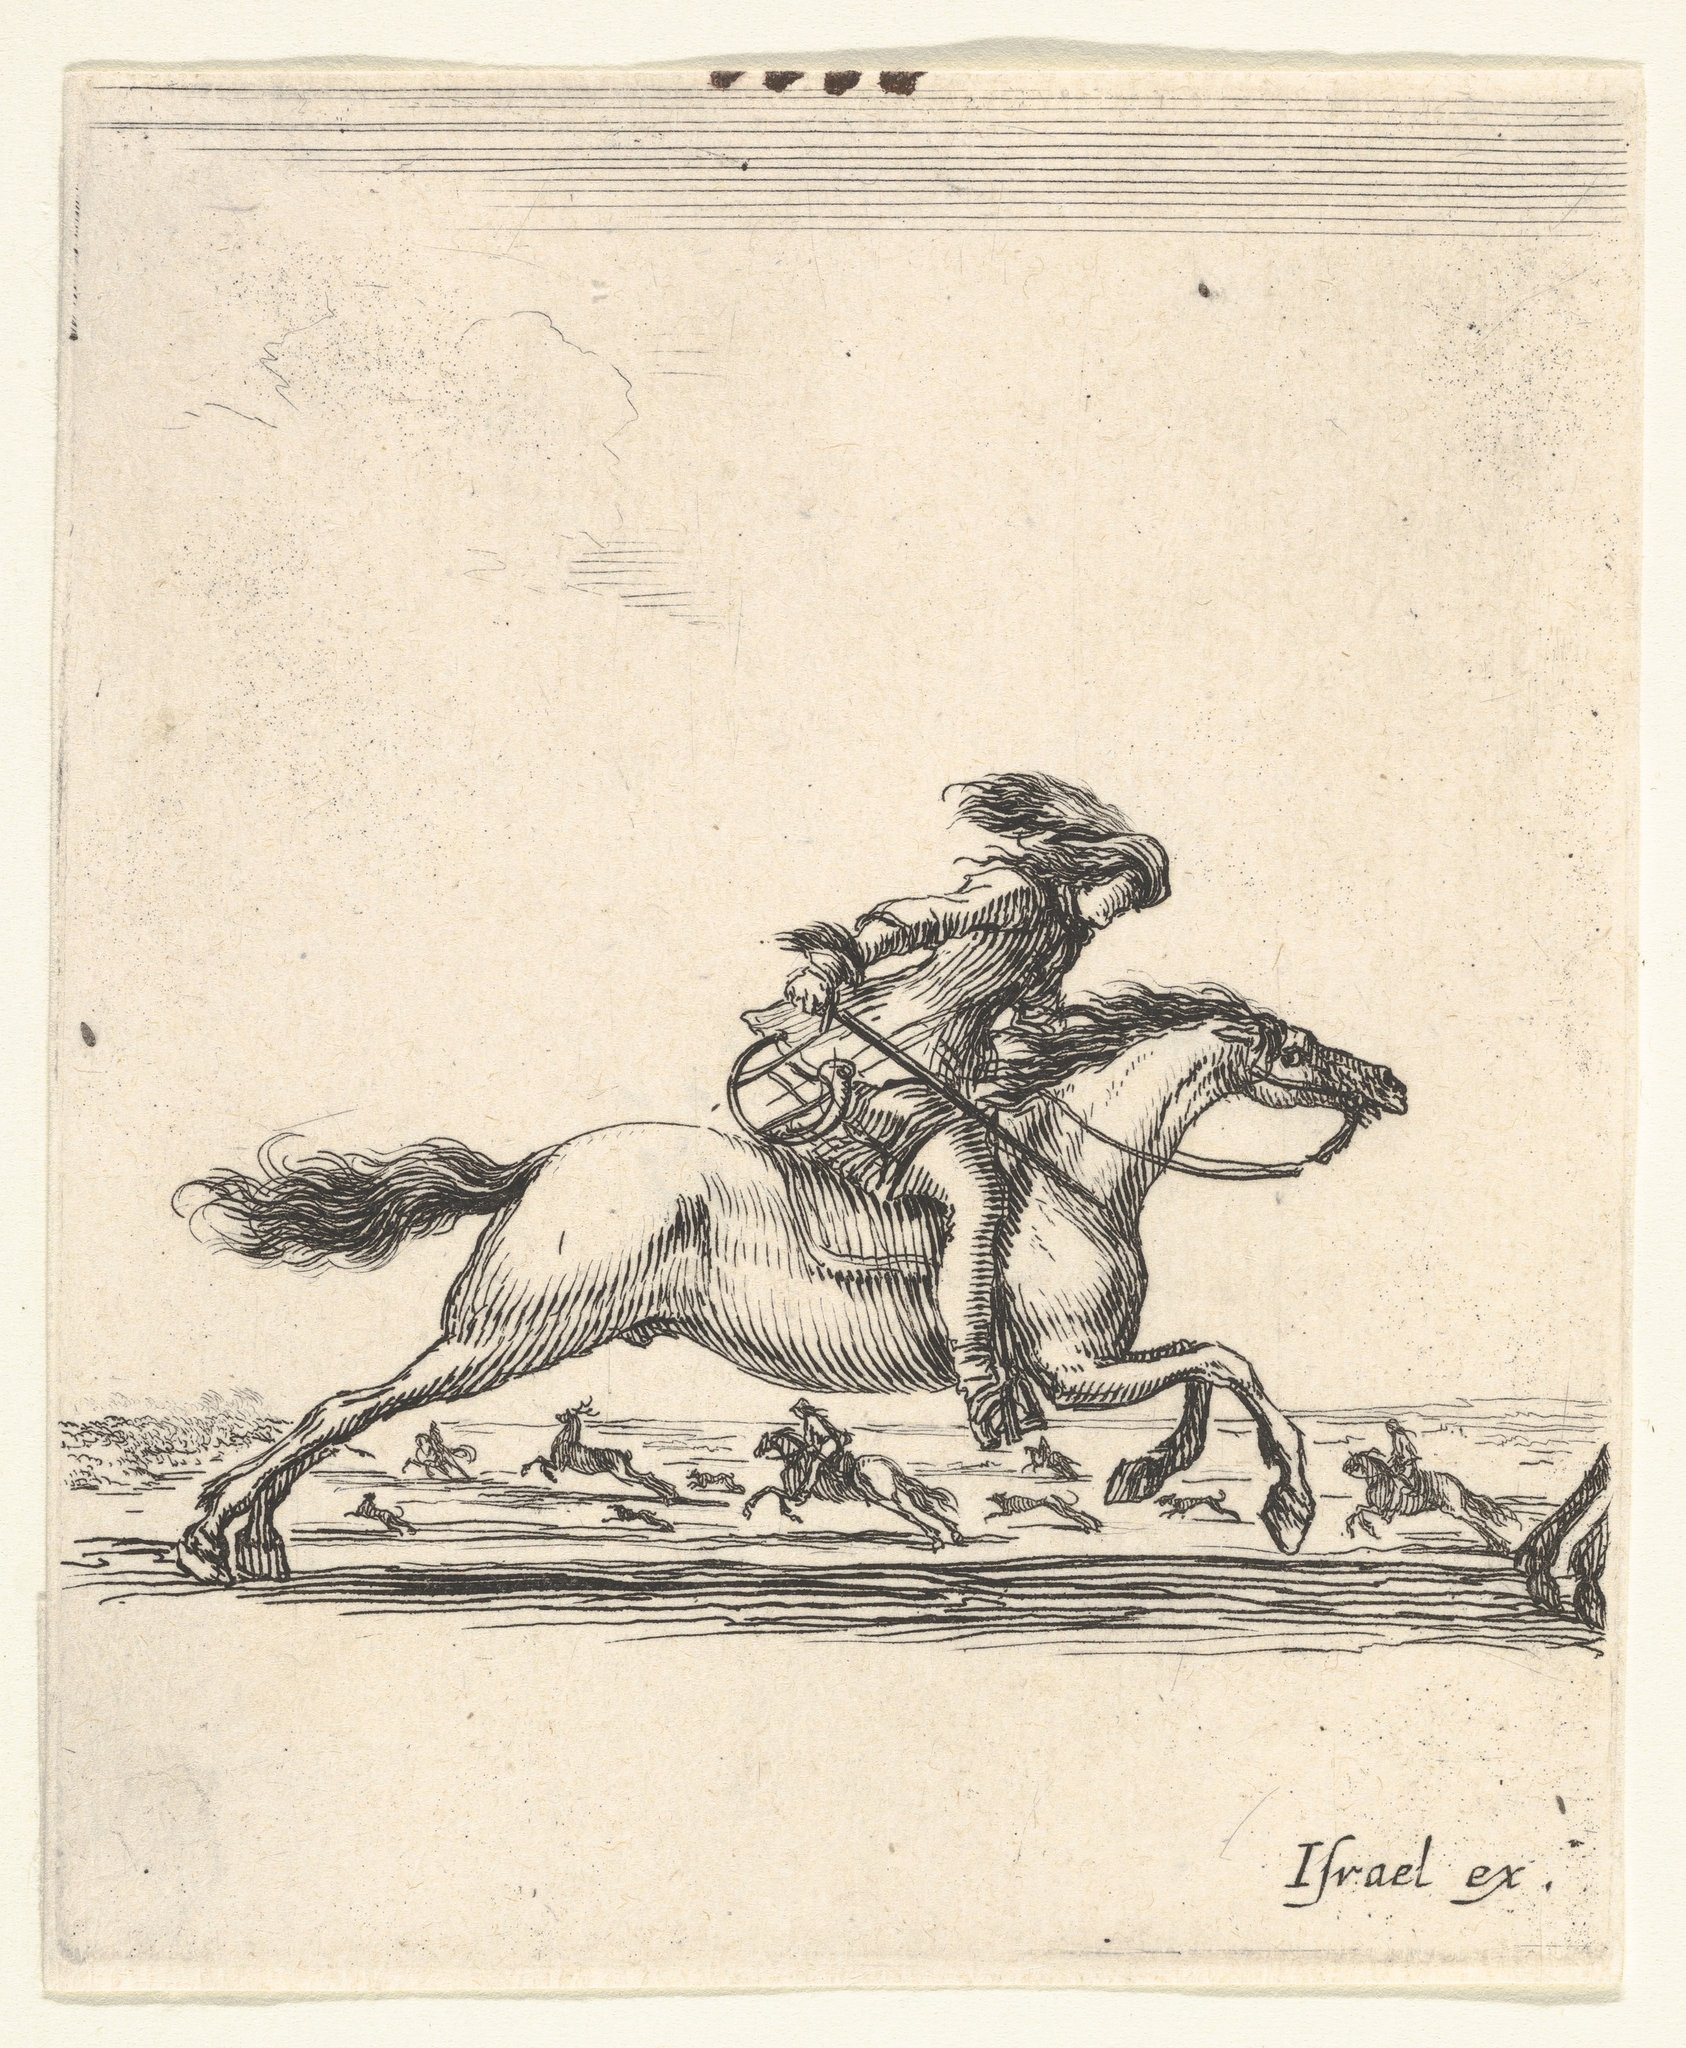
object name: print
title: A horseman with sword in hand galloping towards the right, other horsemen galloping towards the left in the background, from "Various cavalry exercises" (Diverses exercices de cavalerie)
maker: stefano della bella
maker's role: artist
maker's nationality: italian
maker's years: 1610-1664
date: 1642-1645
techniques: etching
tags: swords,men,horses